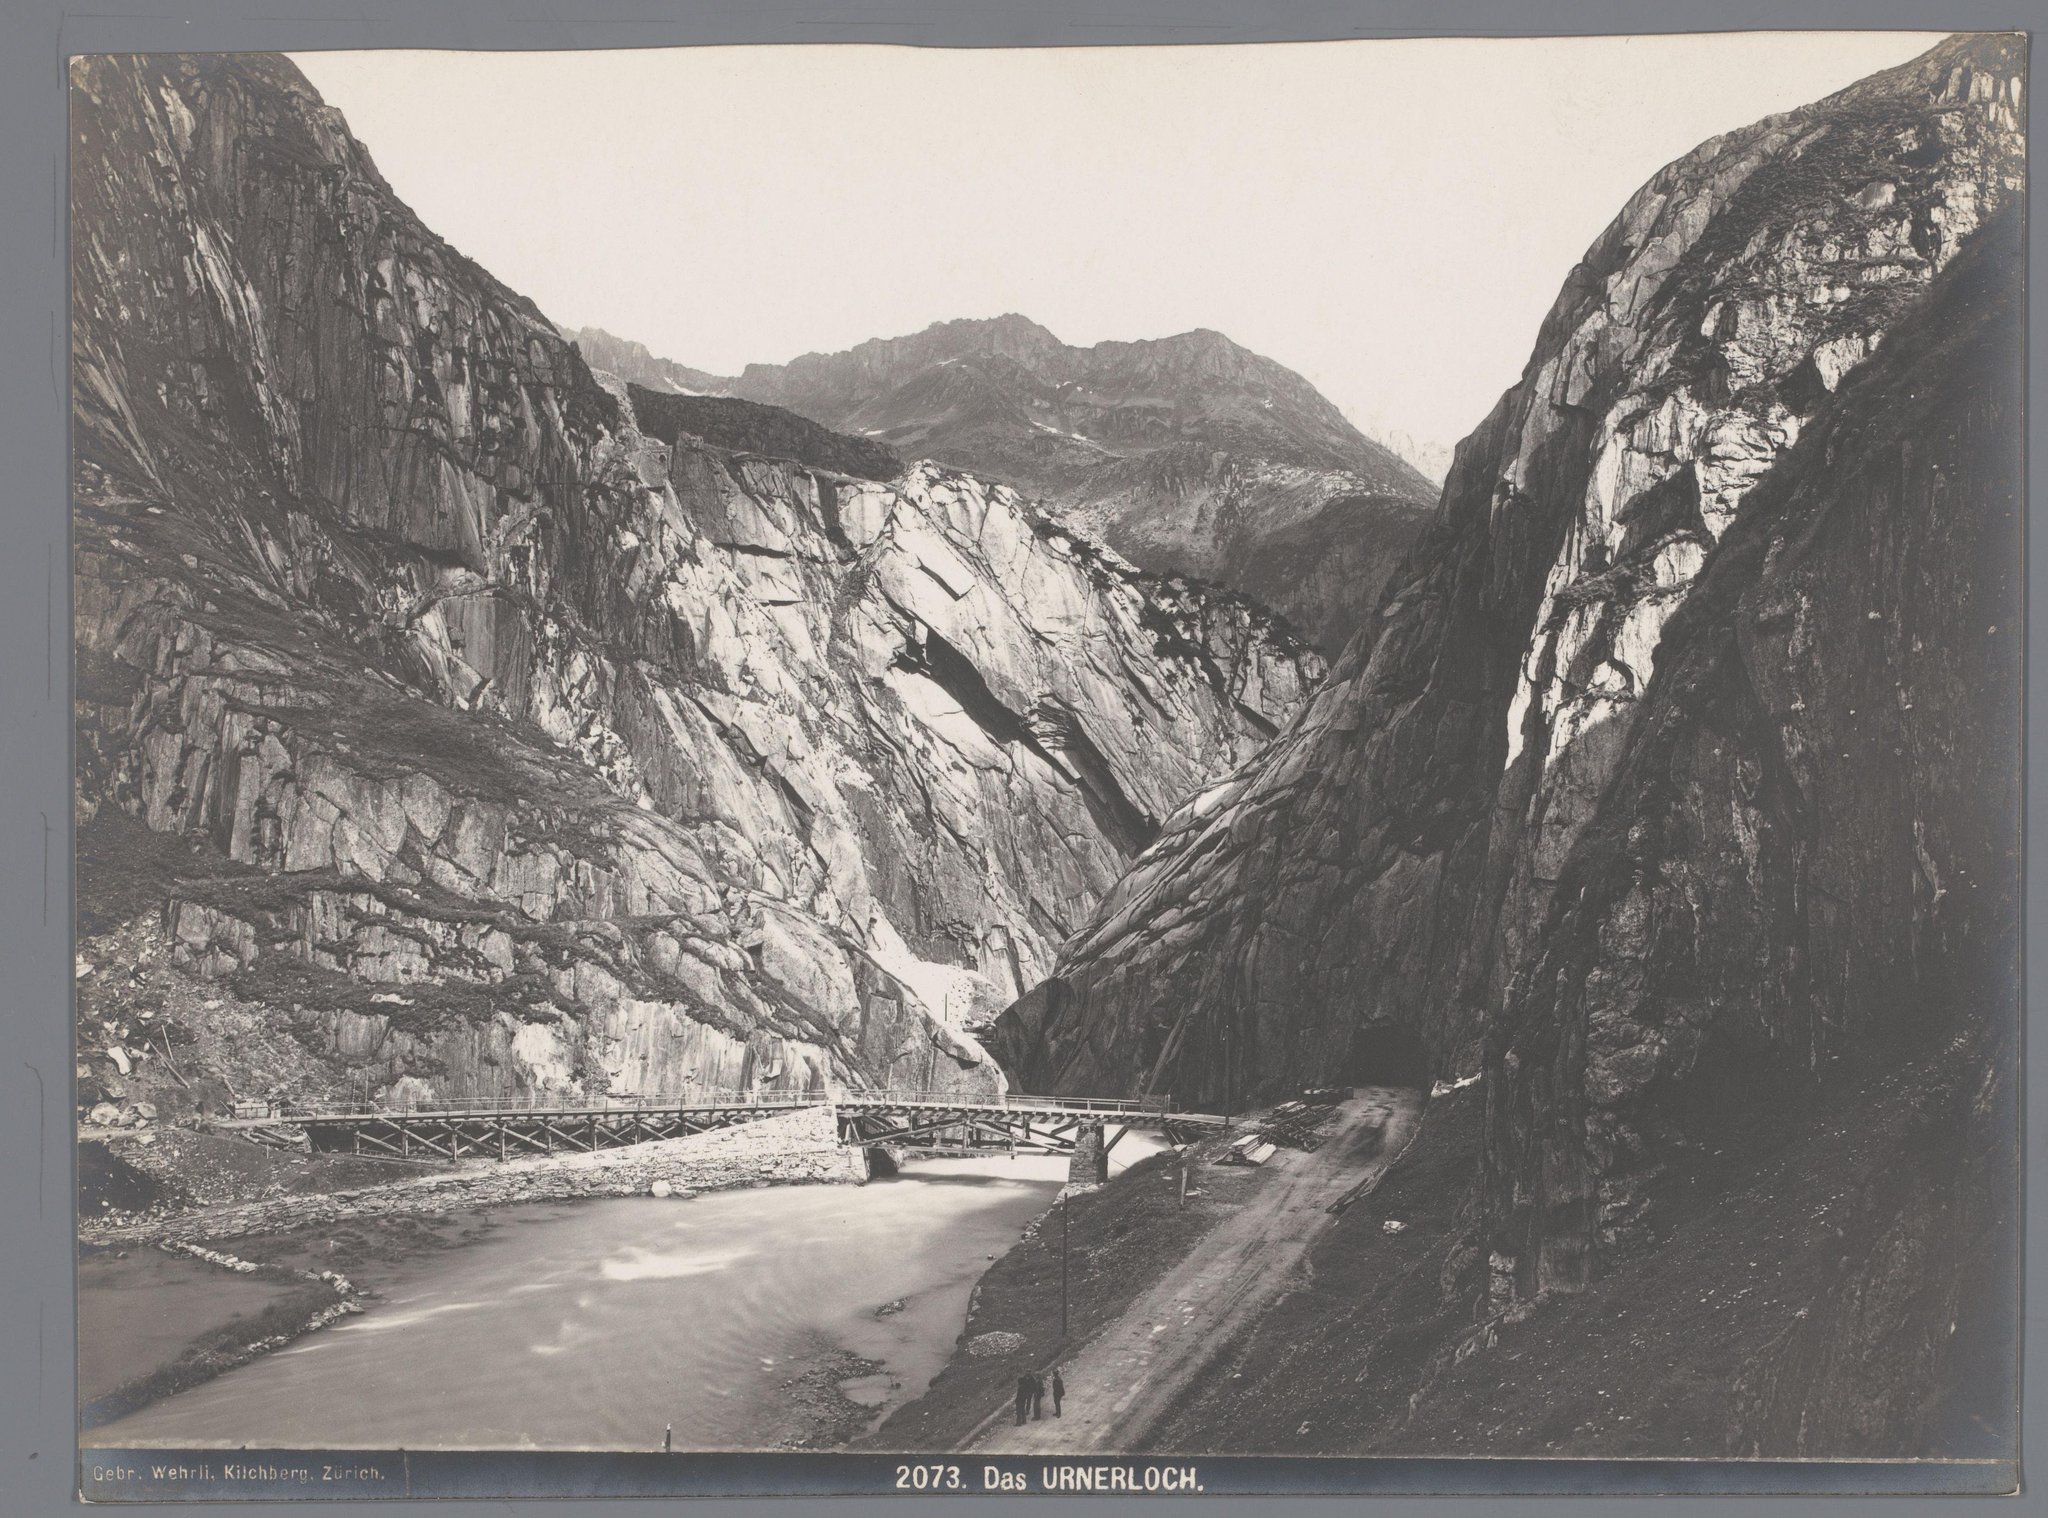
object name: photograph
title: Tunnel "Das Urnerloch" [Schöllenen?] en brug over de Reuss, Gotthardpas, Zwitserland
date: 1900-1925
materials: cardboard, paper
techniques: gelatin silver print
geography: switzerland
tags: switzerland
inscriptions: inscription: ‘2073. Das URNERLOCH.’, inscription: ‘Gebr. Wehrli, Kilchberg, Zürich.’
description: Rechts van het diepe dal tussen steile rotsen is de ingang naar de 64-meter lange tunnel "Urnerloch" te zien, gebouwd tussen 20. 09. 1707 en 15.08. 1708. Over de rivier de Reuss is een lage brug te zien.